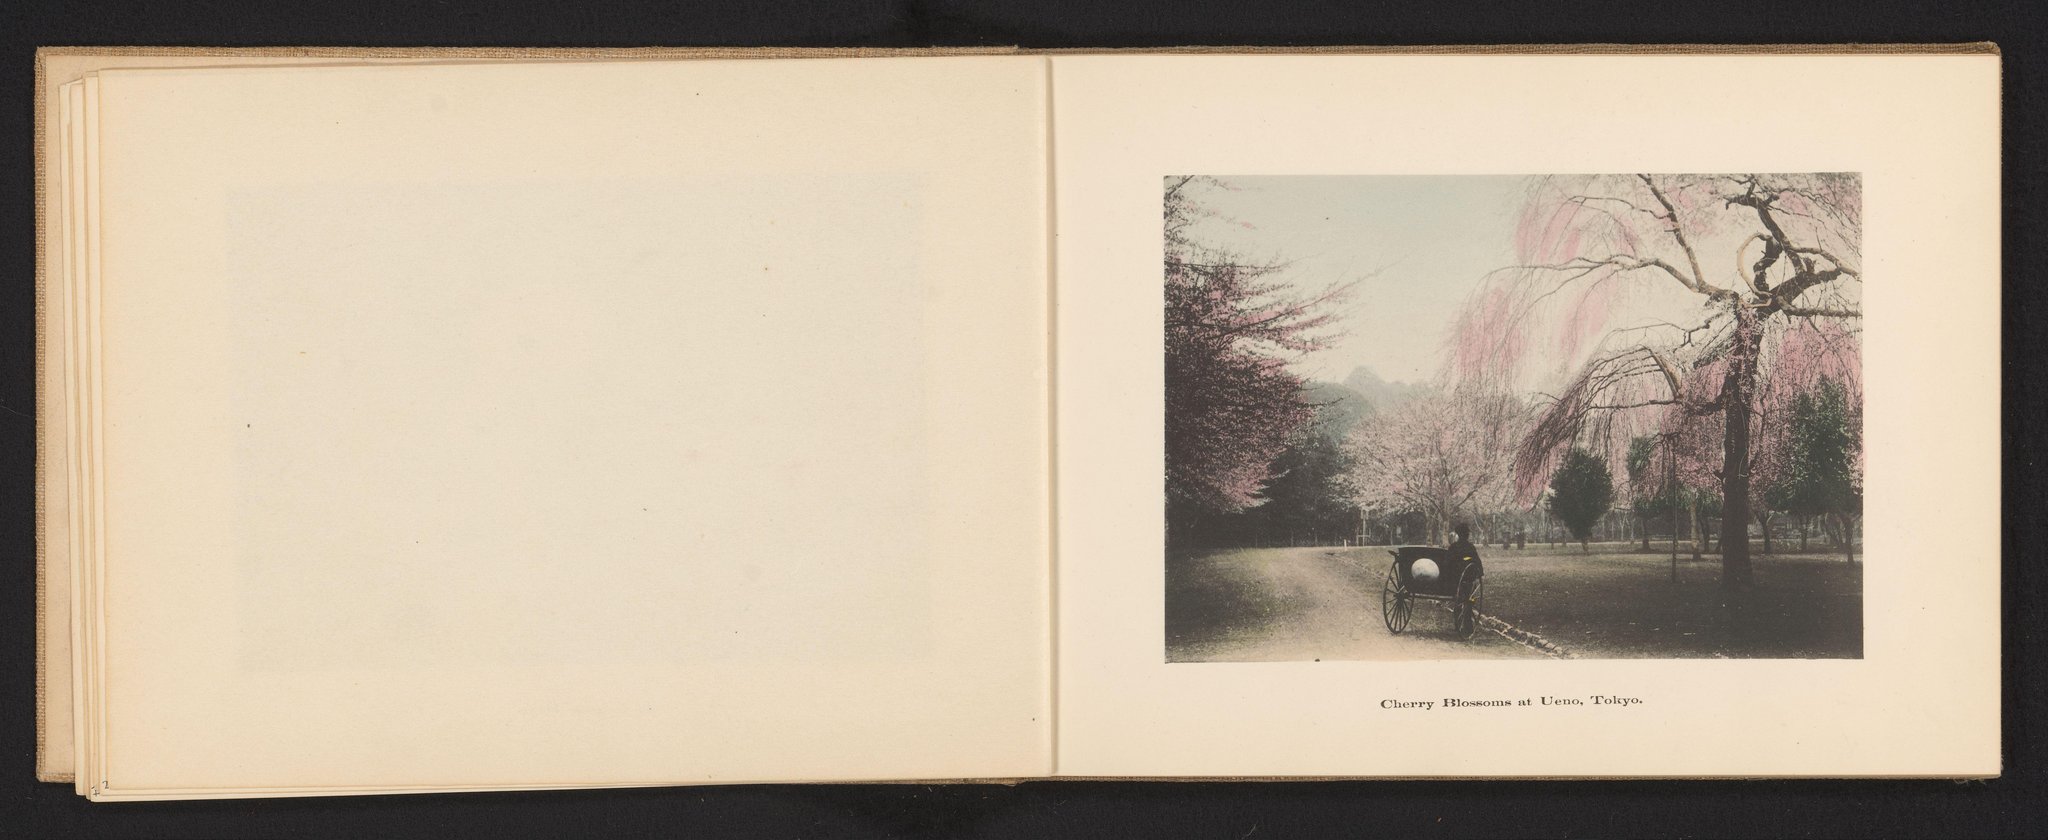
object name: photomechanical print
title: Cherry Blossoms at Ueno, Tokyo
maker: kōzaburō tamamura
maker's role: fotograaf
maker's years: 1856-1923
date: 1895-1905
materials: paper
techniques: photograph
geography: tokyo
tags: hand-cart, trees: cherry-tree, public gardens, park